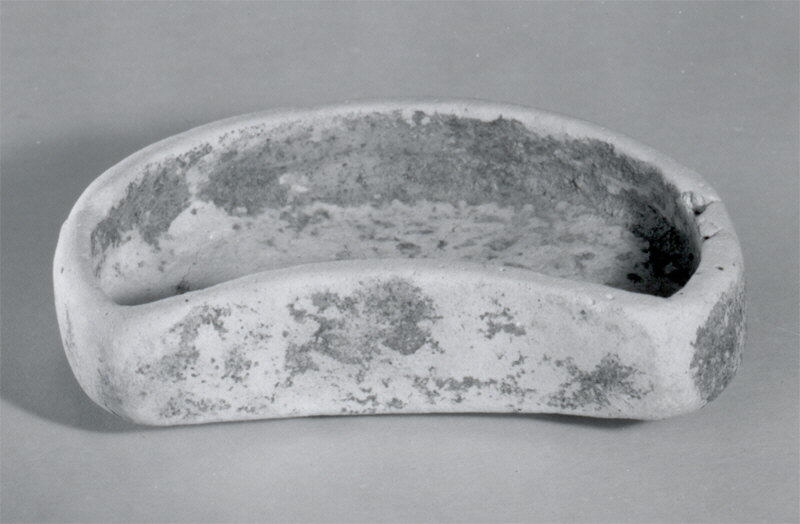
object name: box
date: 2200-1800 BCE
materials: faience, glaze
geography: bactria-margiana